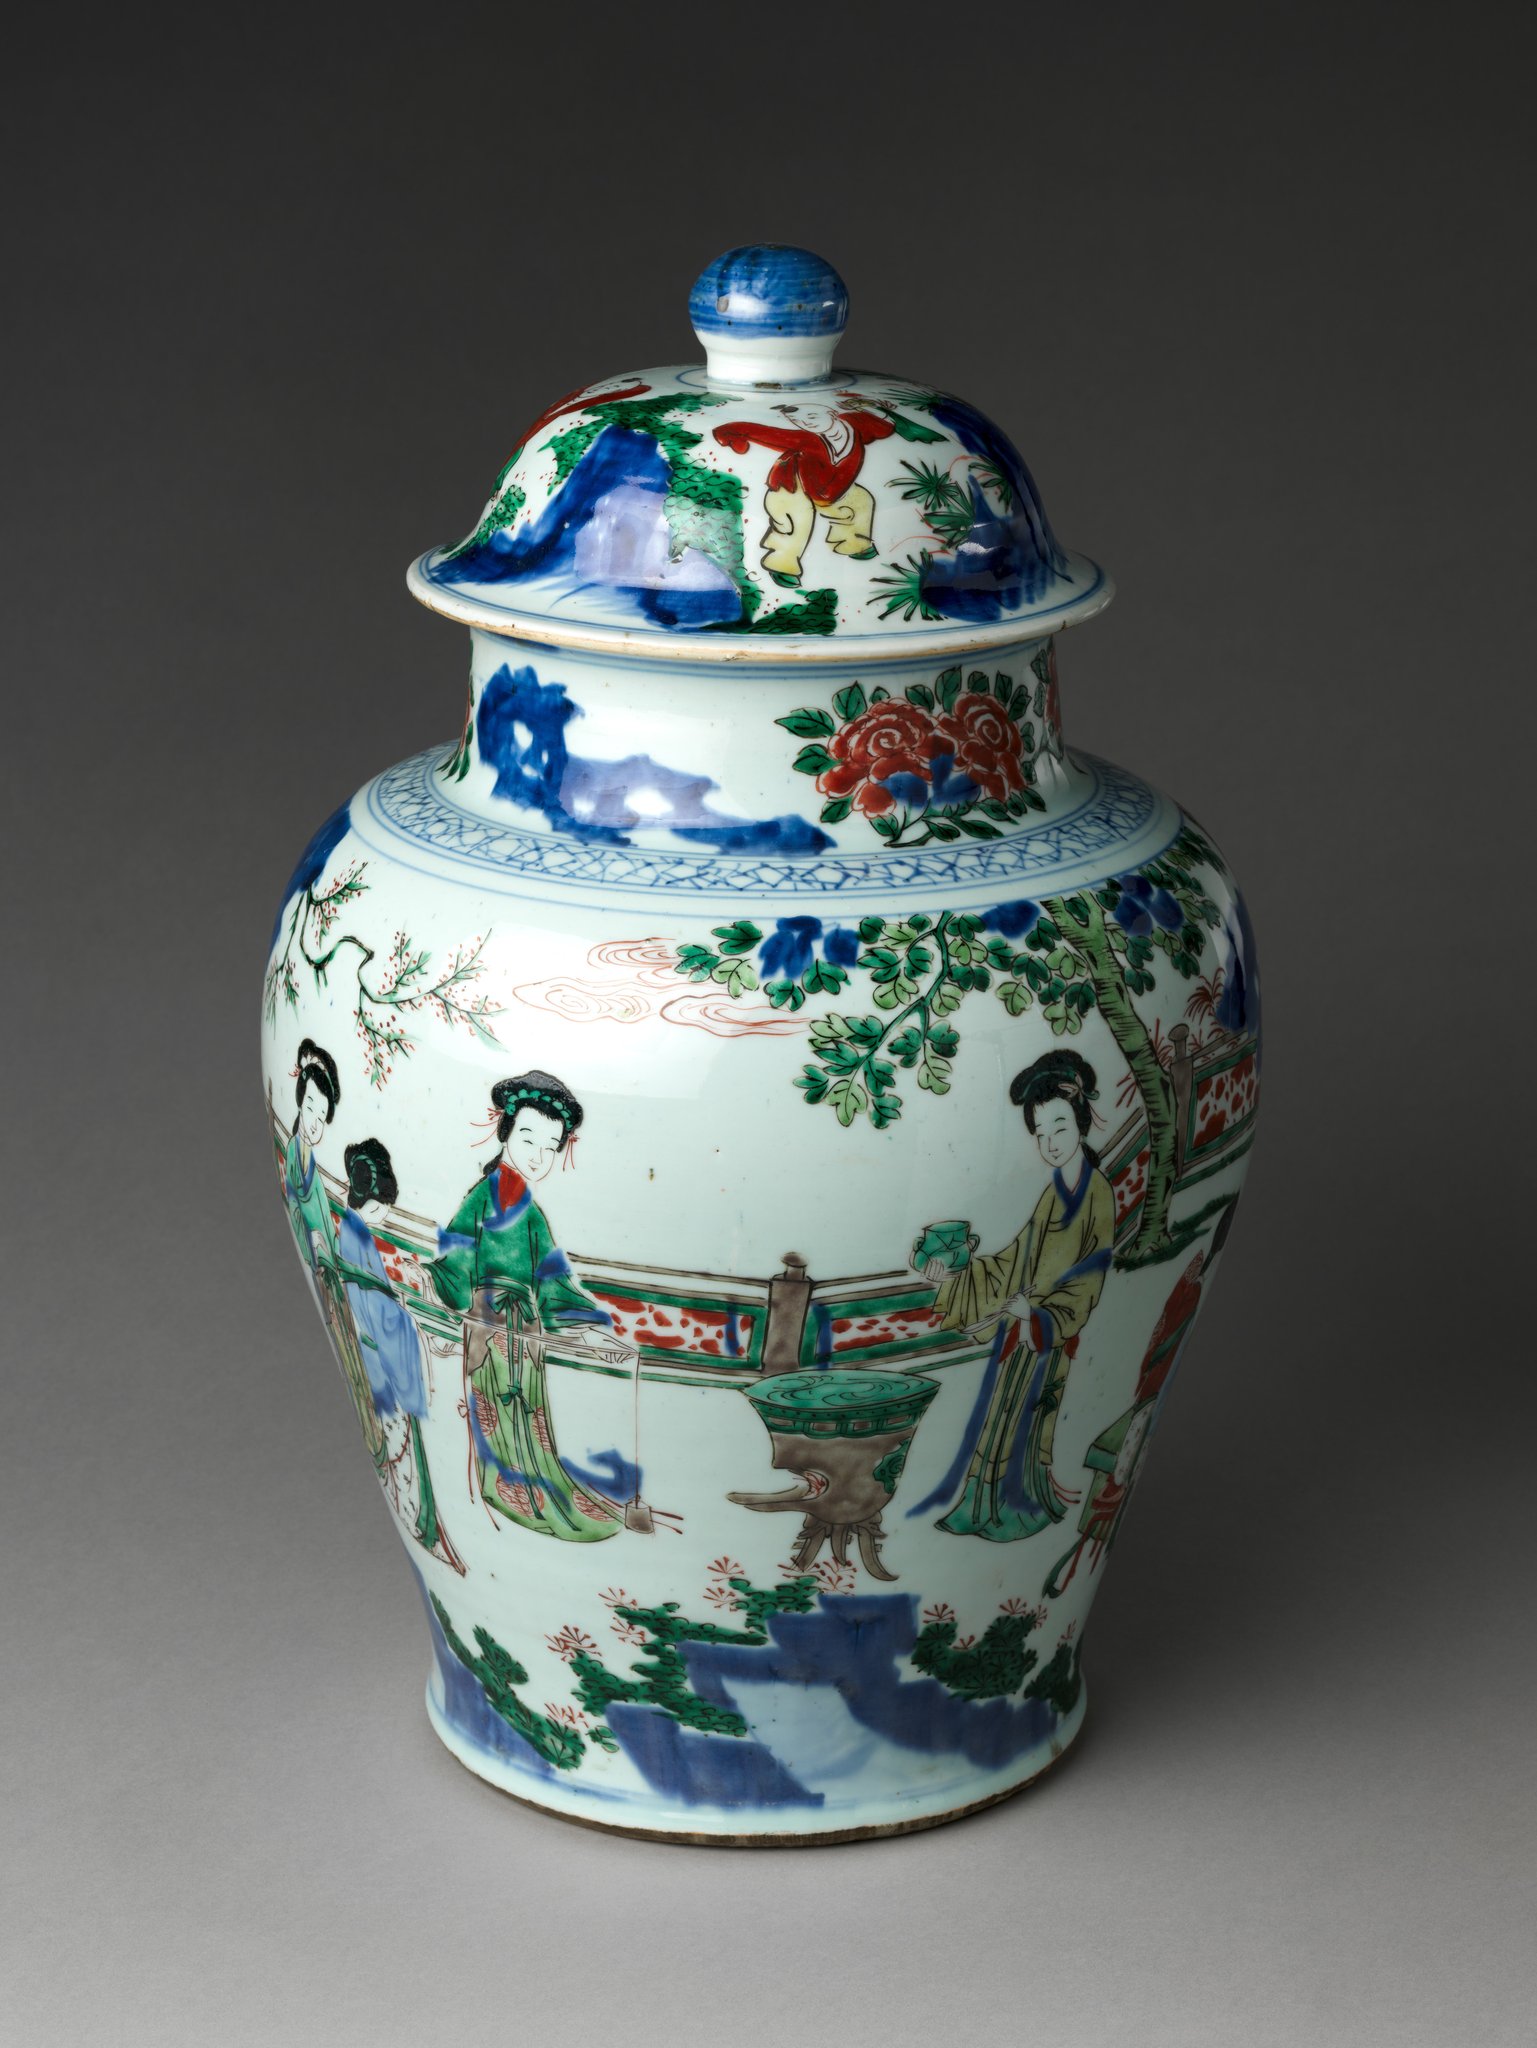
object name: jar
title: Jar with women at leisure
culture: chinese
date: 1634-1666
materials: cobalt, enamel, porcelain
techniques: overglaze, painting, polychrome, underglaze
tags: women,flowers,trees